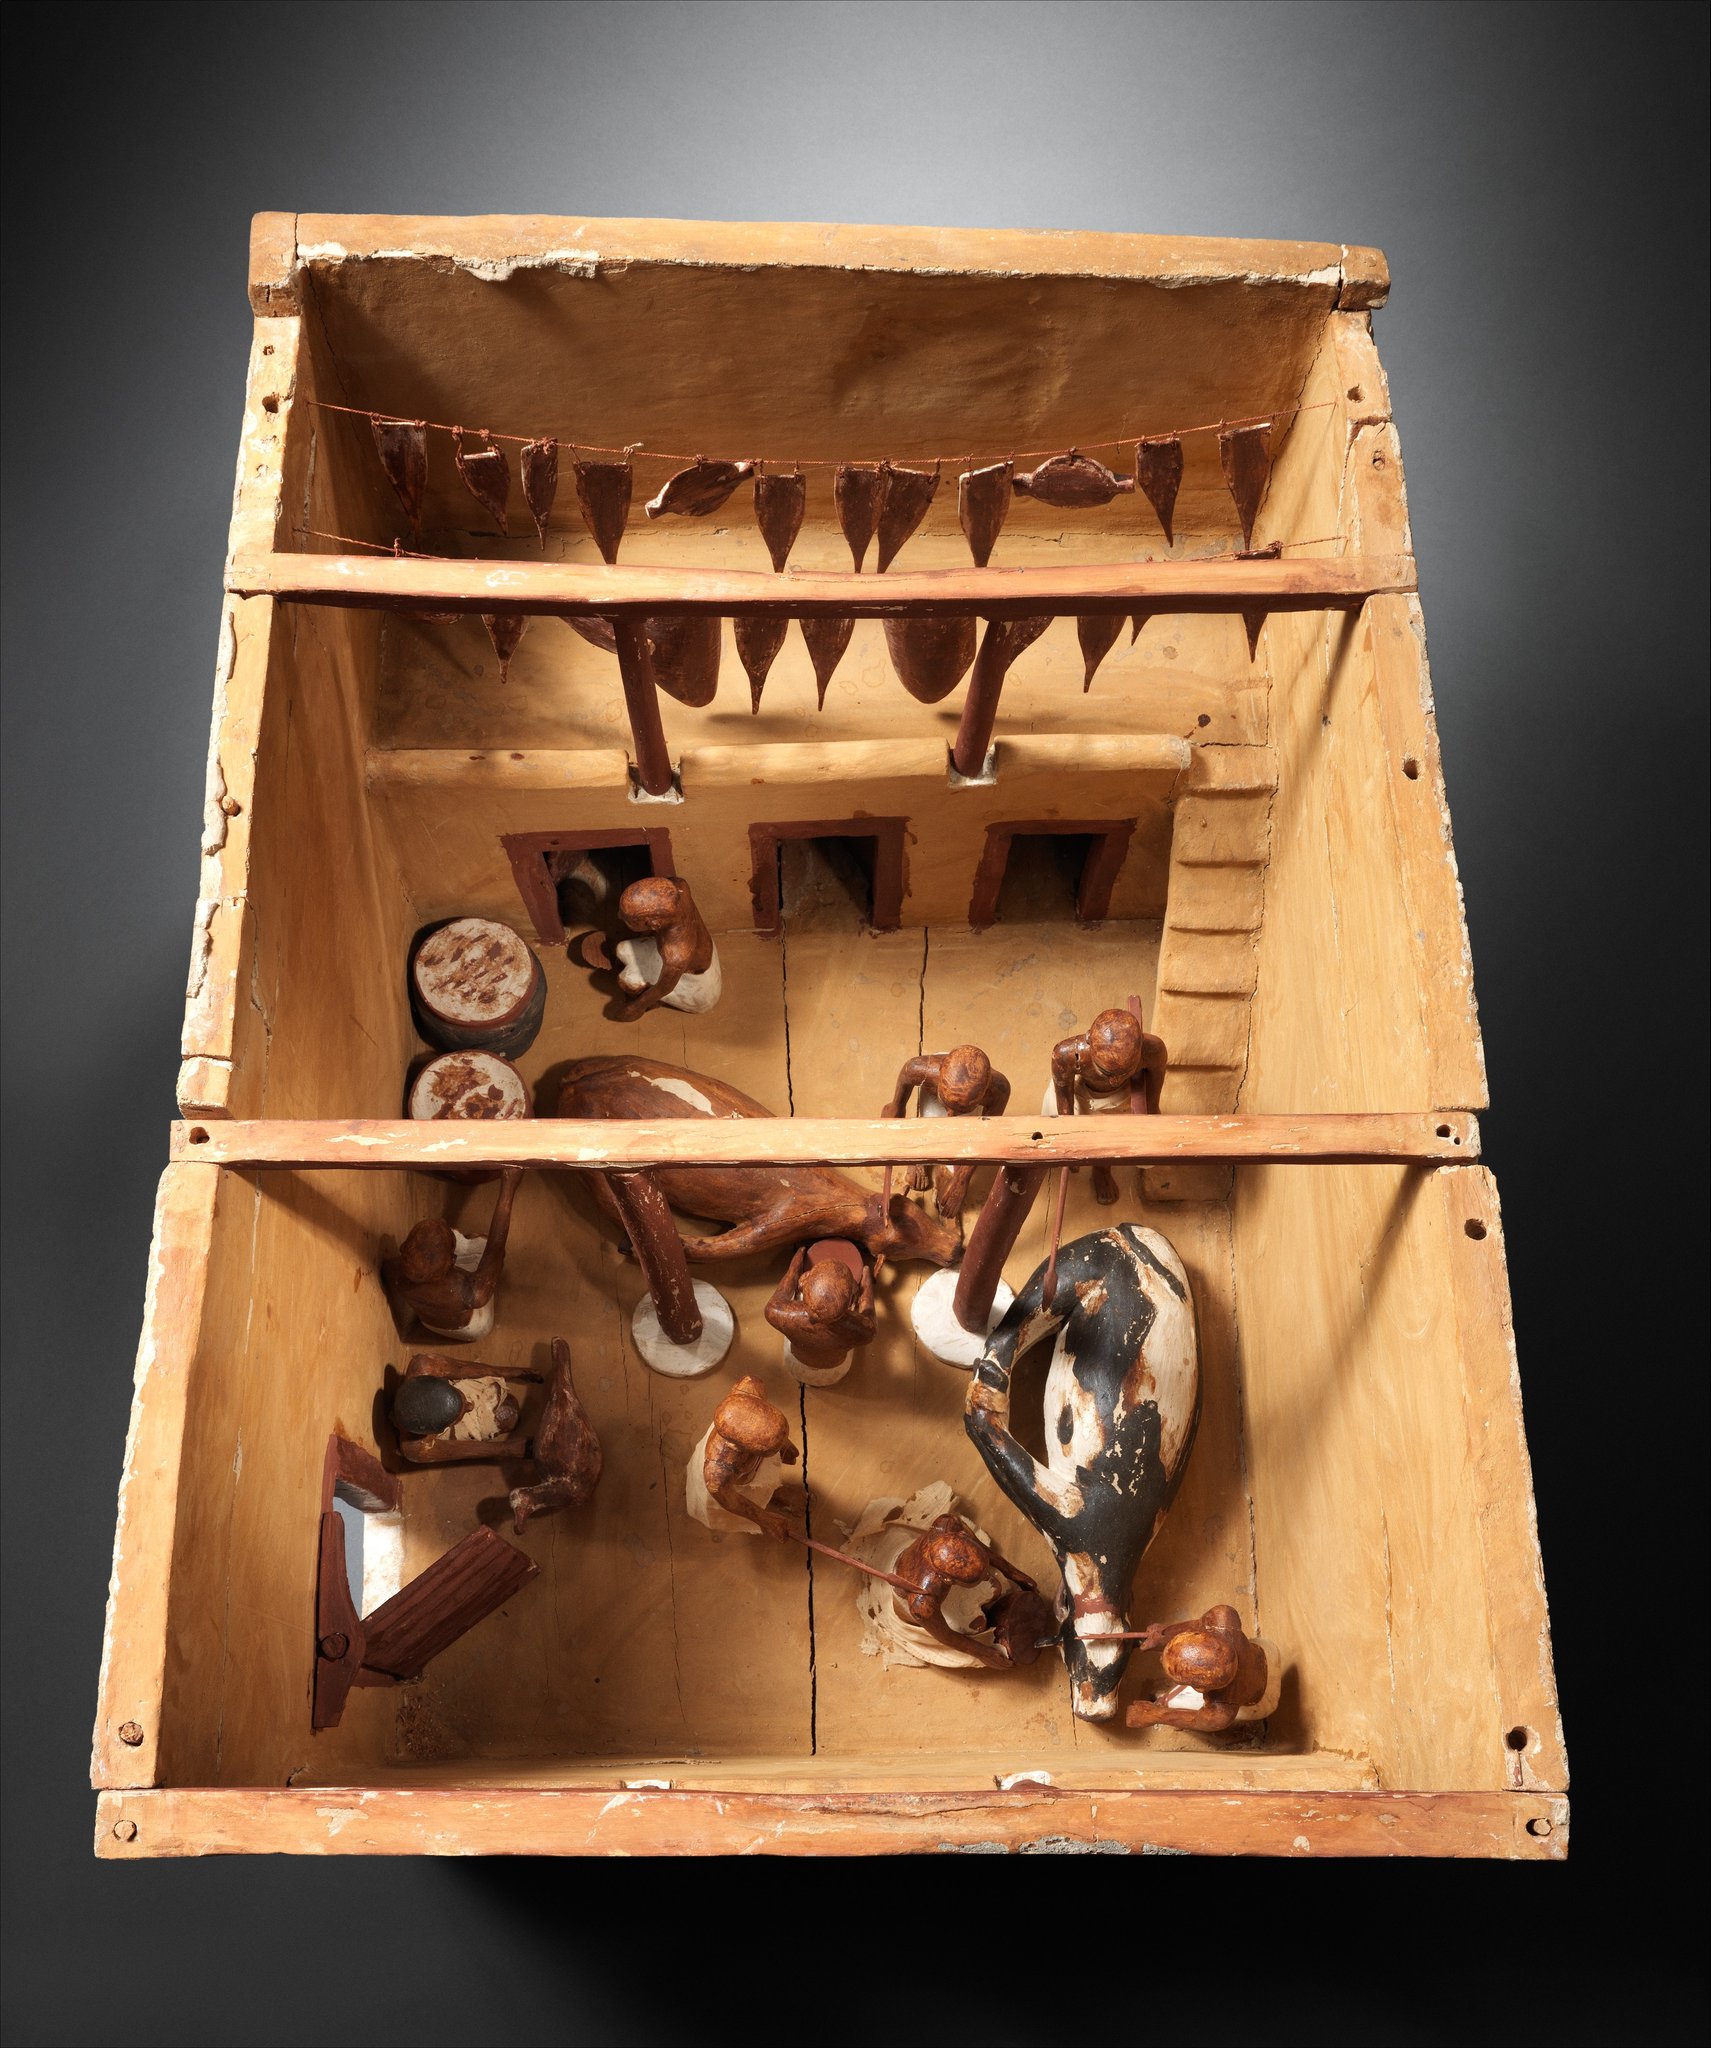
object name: model, butcher, meketre, slaughter, cow, cattle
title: Model of a Slaughter House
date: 1981-1975 BCE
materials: paint, plaster, wood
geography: egypt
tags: animals,men,meketre-models